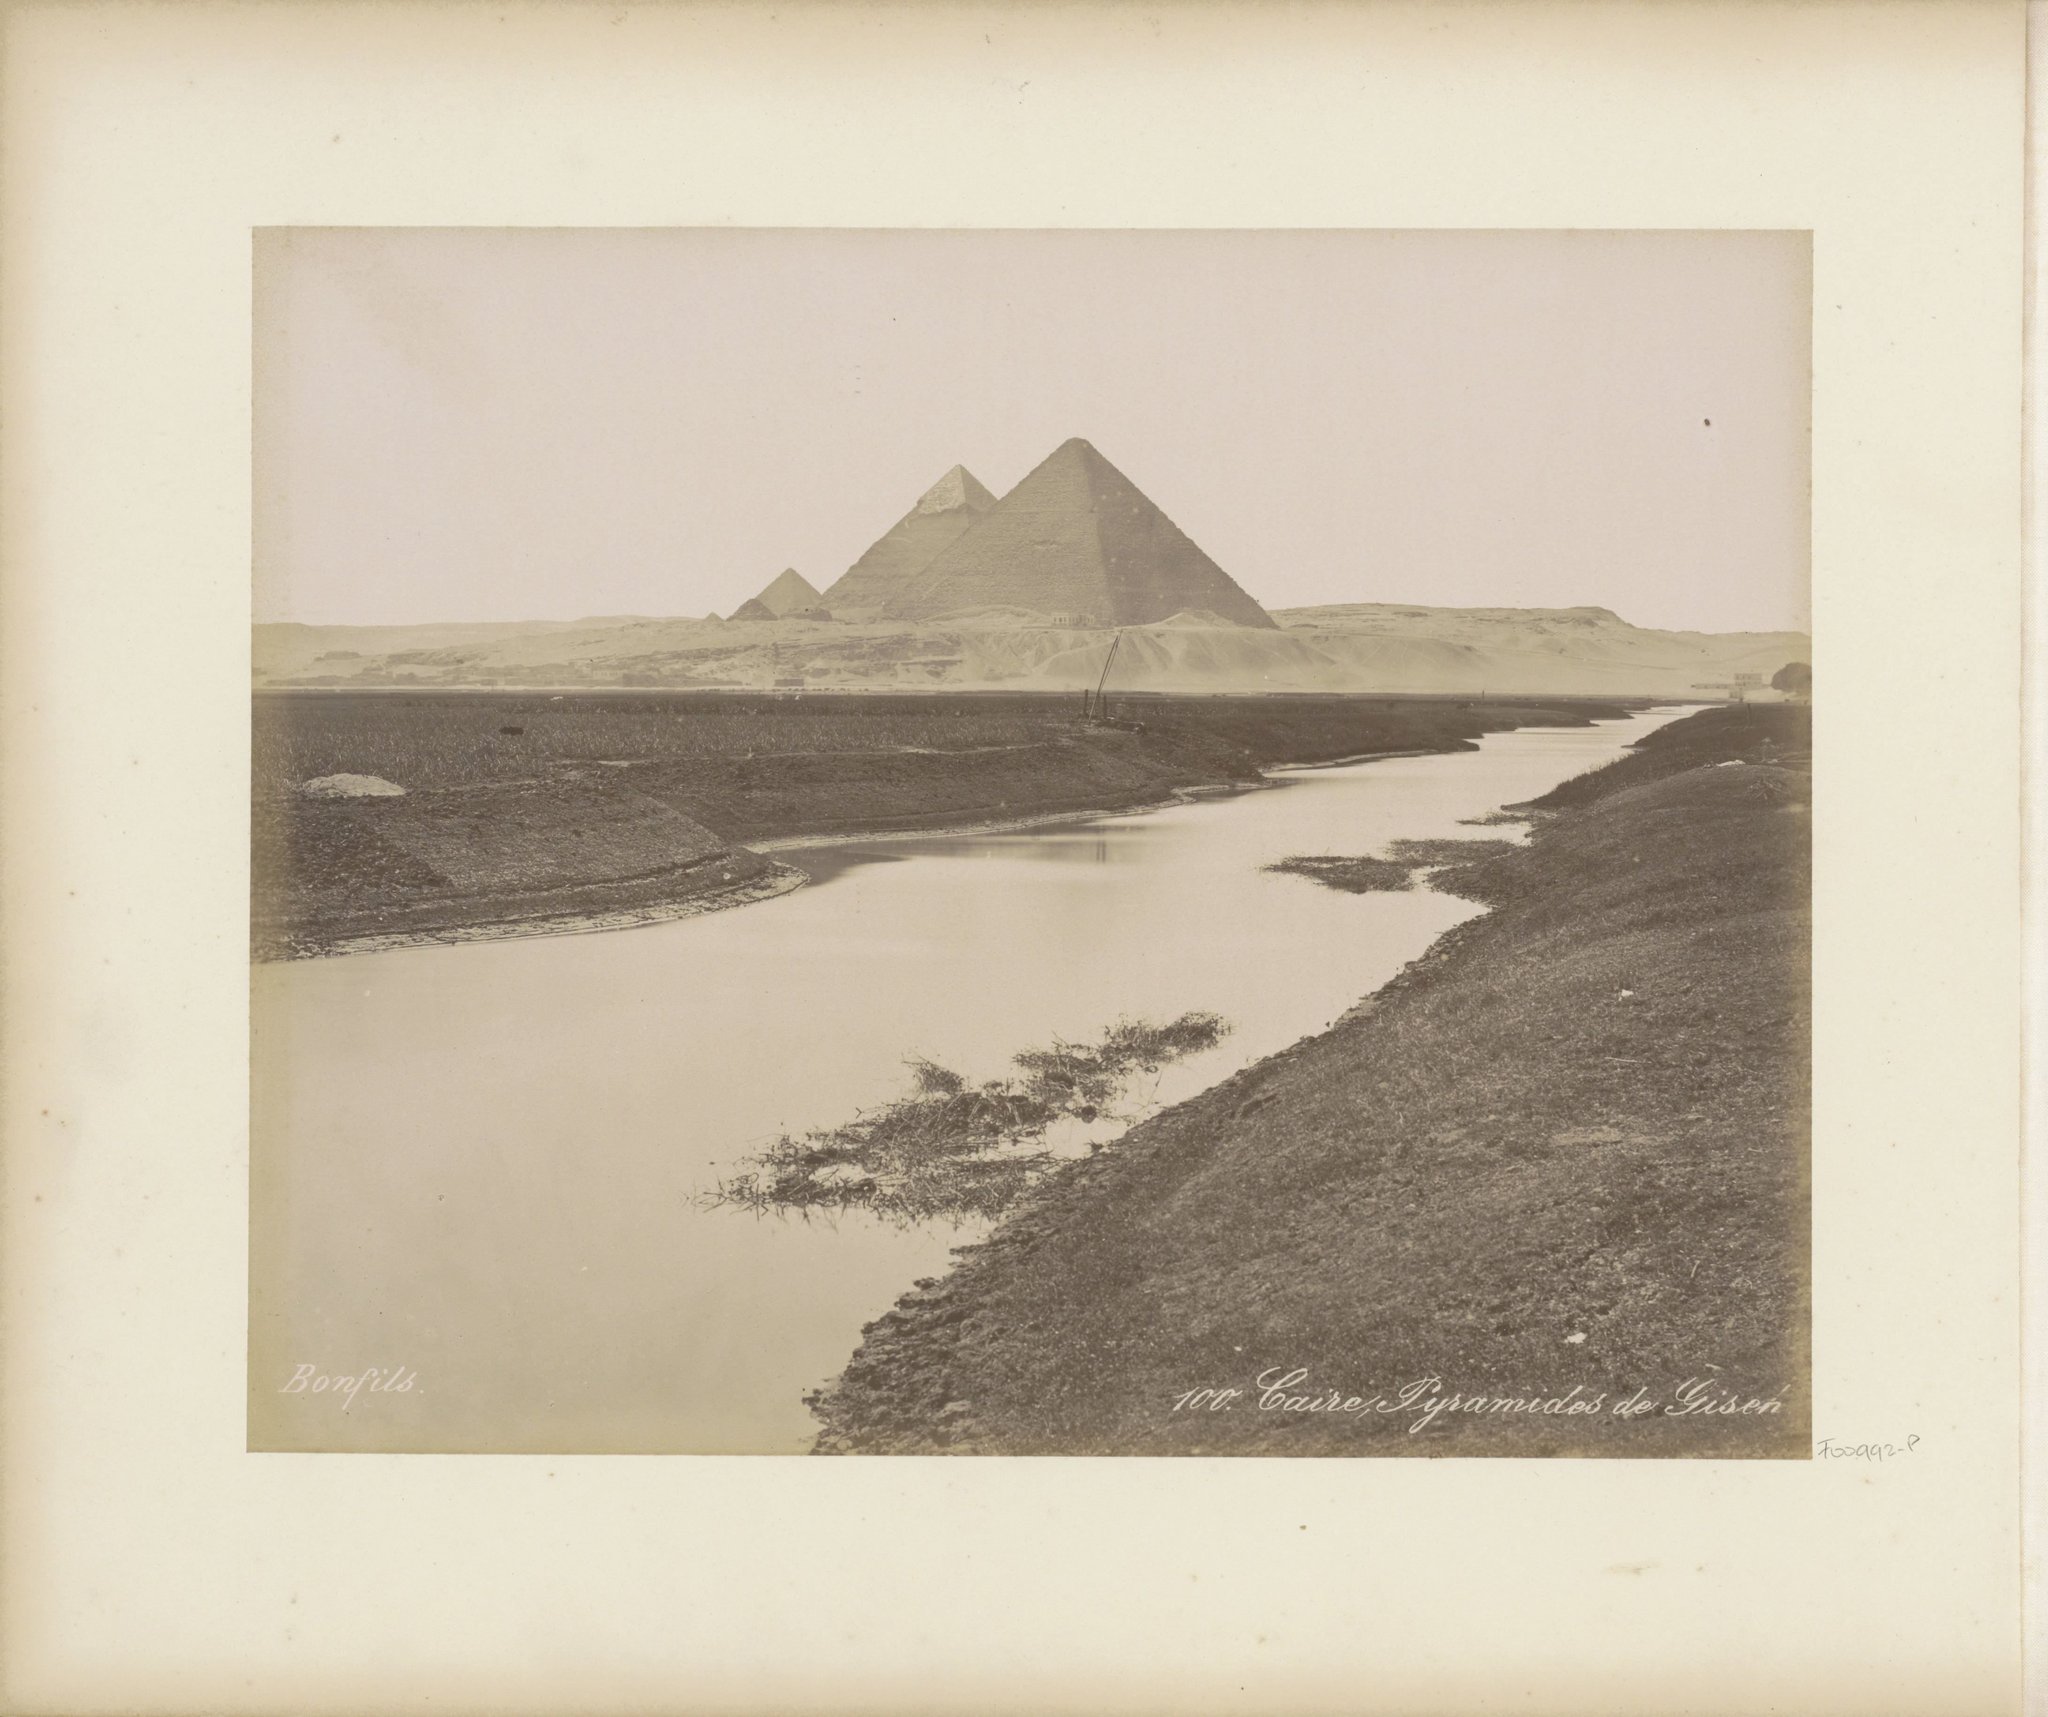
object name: photograph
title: Gezicht op de piramides van Gizeh bij Caïro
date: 1870-1898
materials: cardboard, paper, photographic support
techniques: albumen print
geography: gizeh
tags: pyramid (historical grave form)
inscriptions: negative number: ‘100’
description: Onderdeel van Reisalbum met 80 foto's van Egypte.